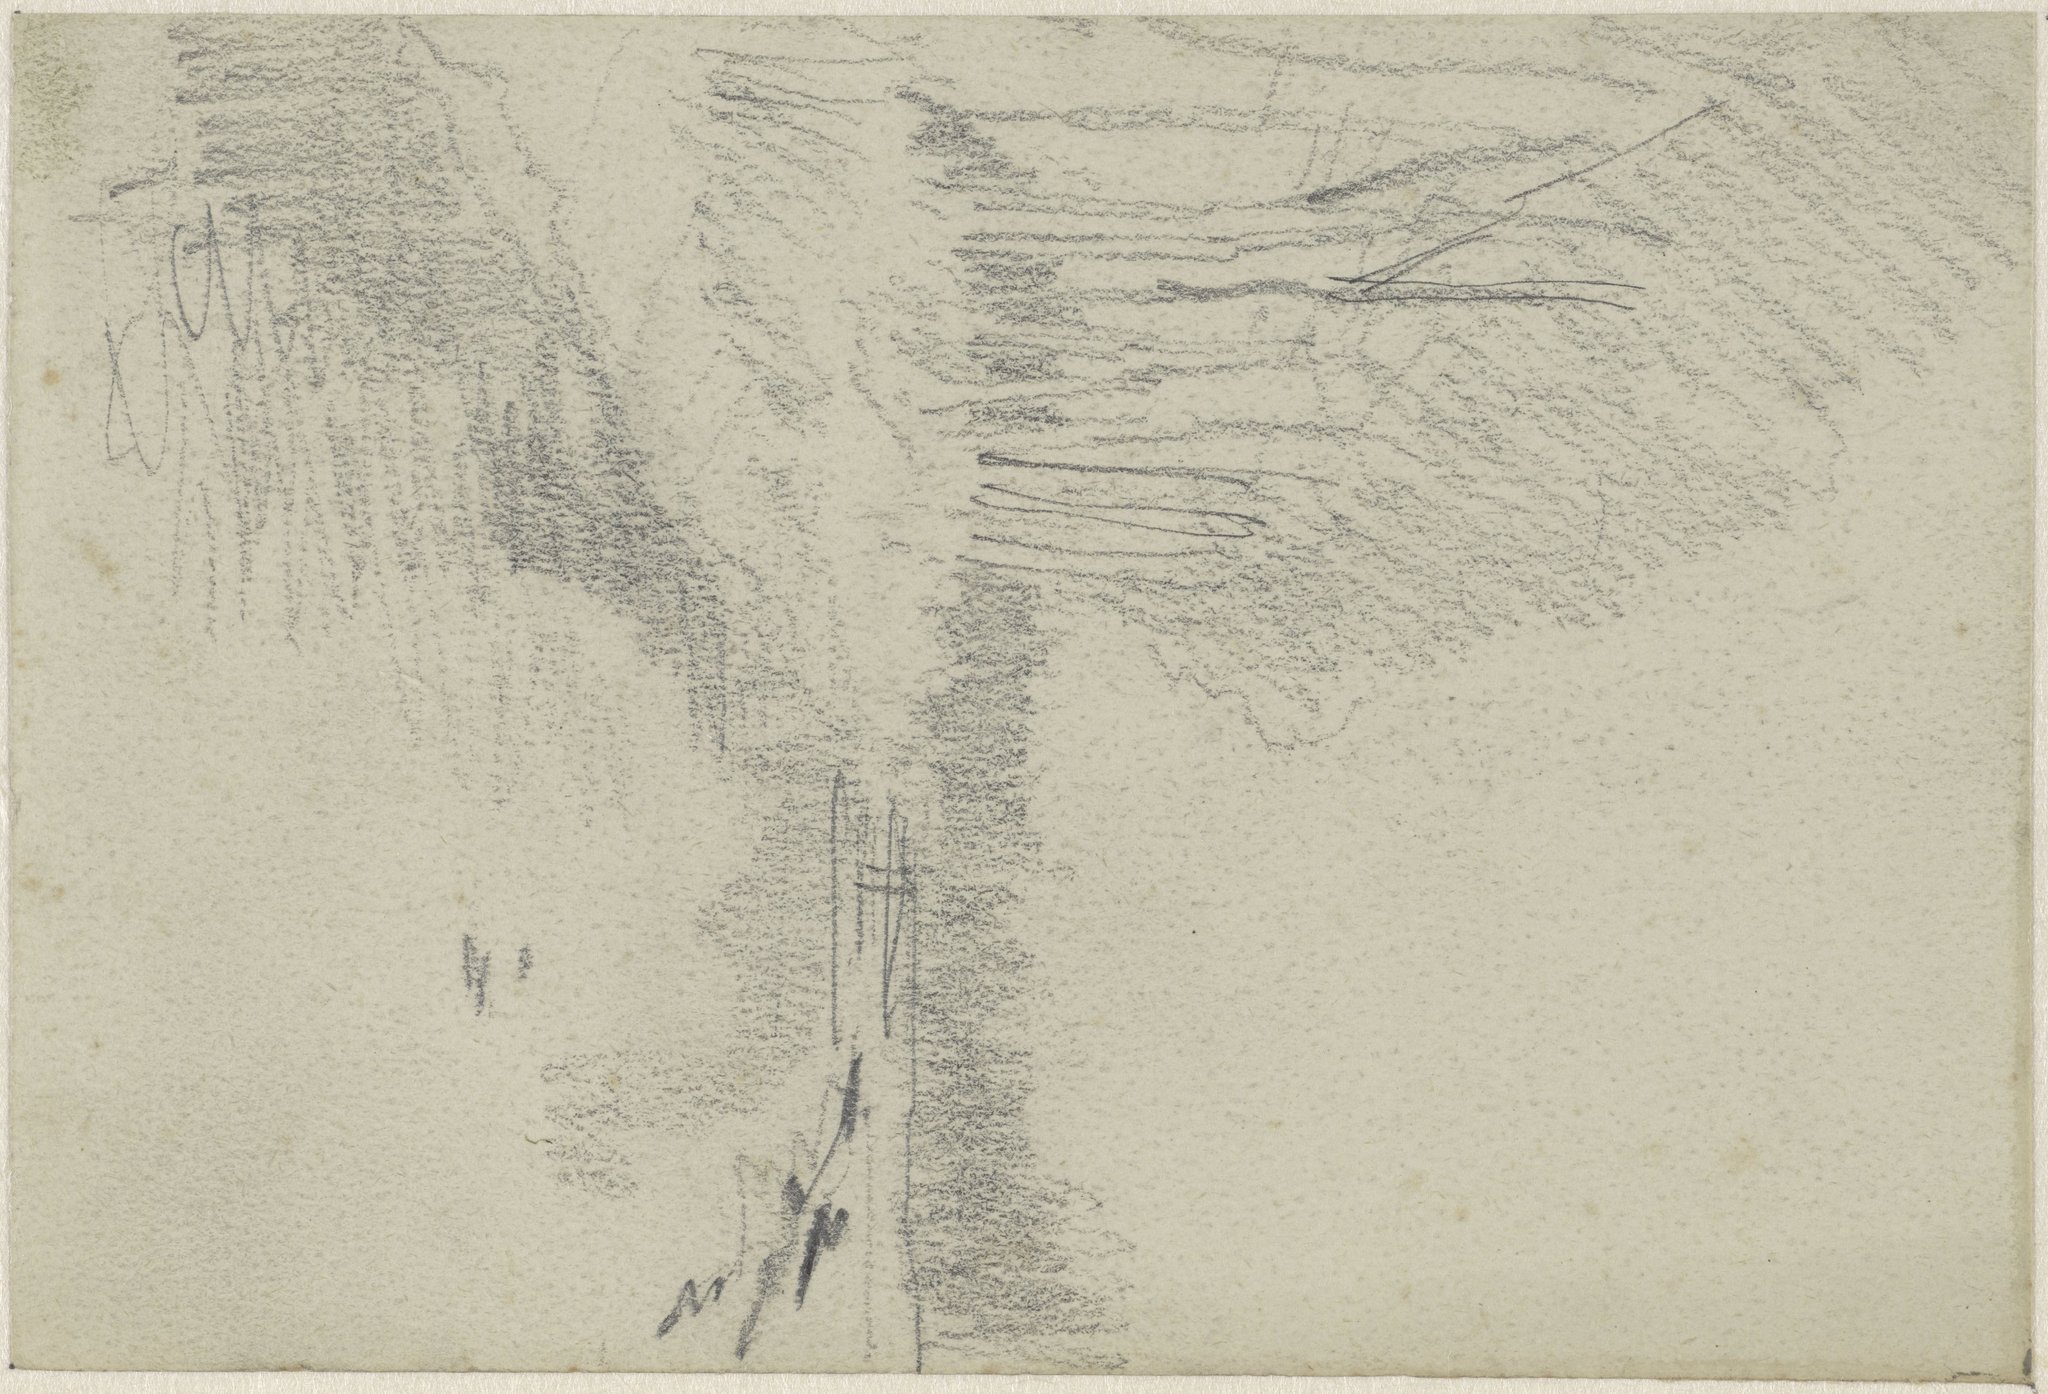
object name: drawing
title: Landschap met bomen langs een vaart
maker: anton mauve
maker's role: draughtsman, painter, print maker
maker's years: 1838-1888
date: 1848-1888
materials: paper, pencil